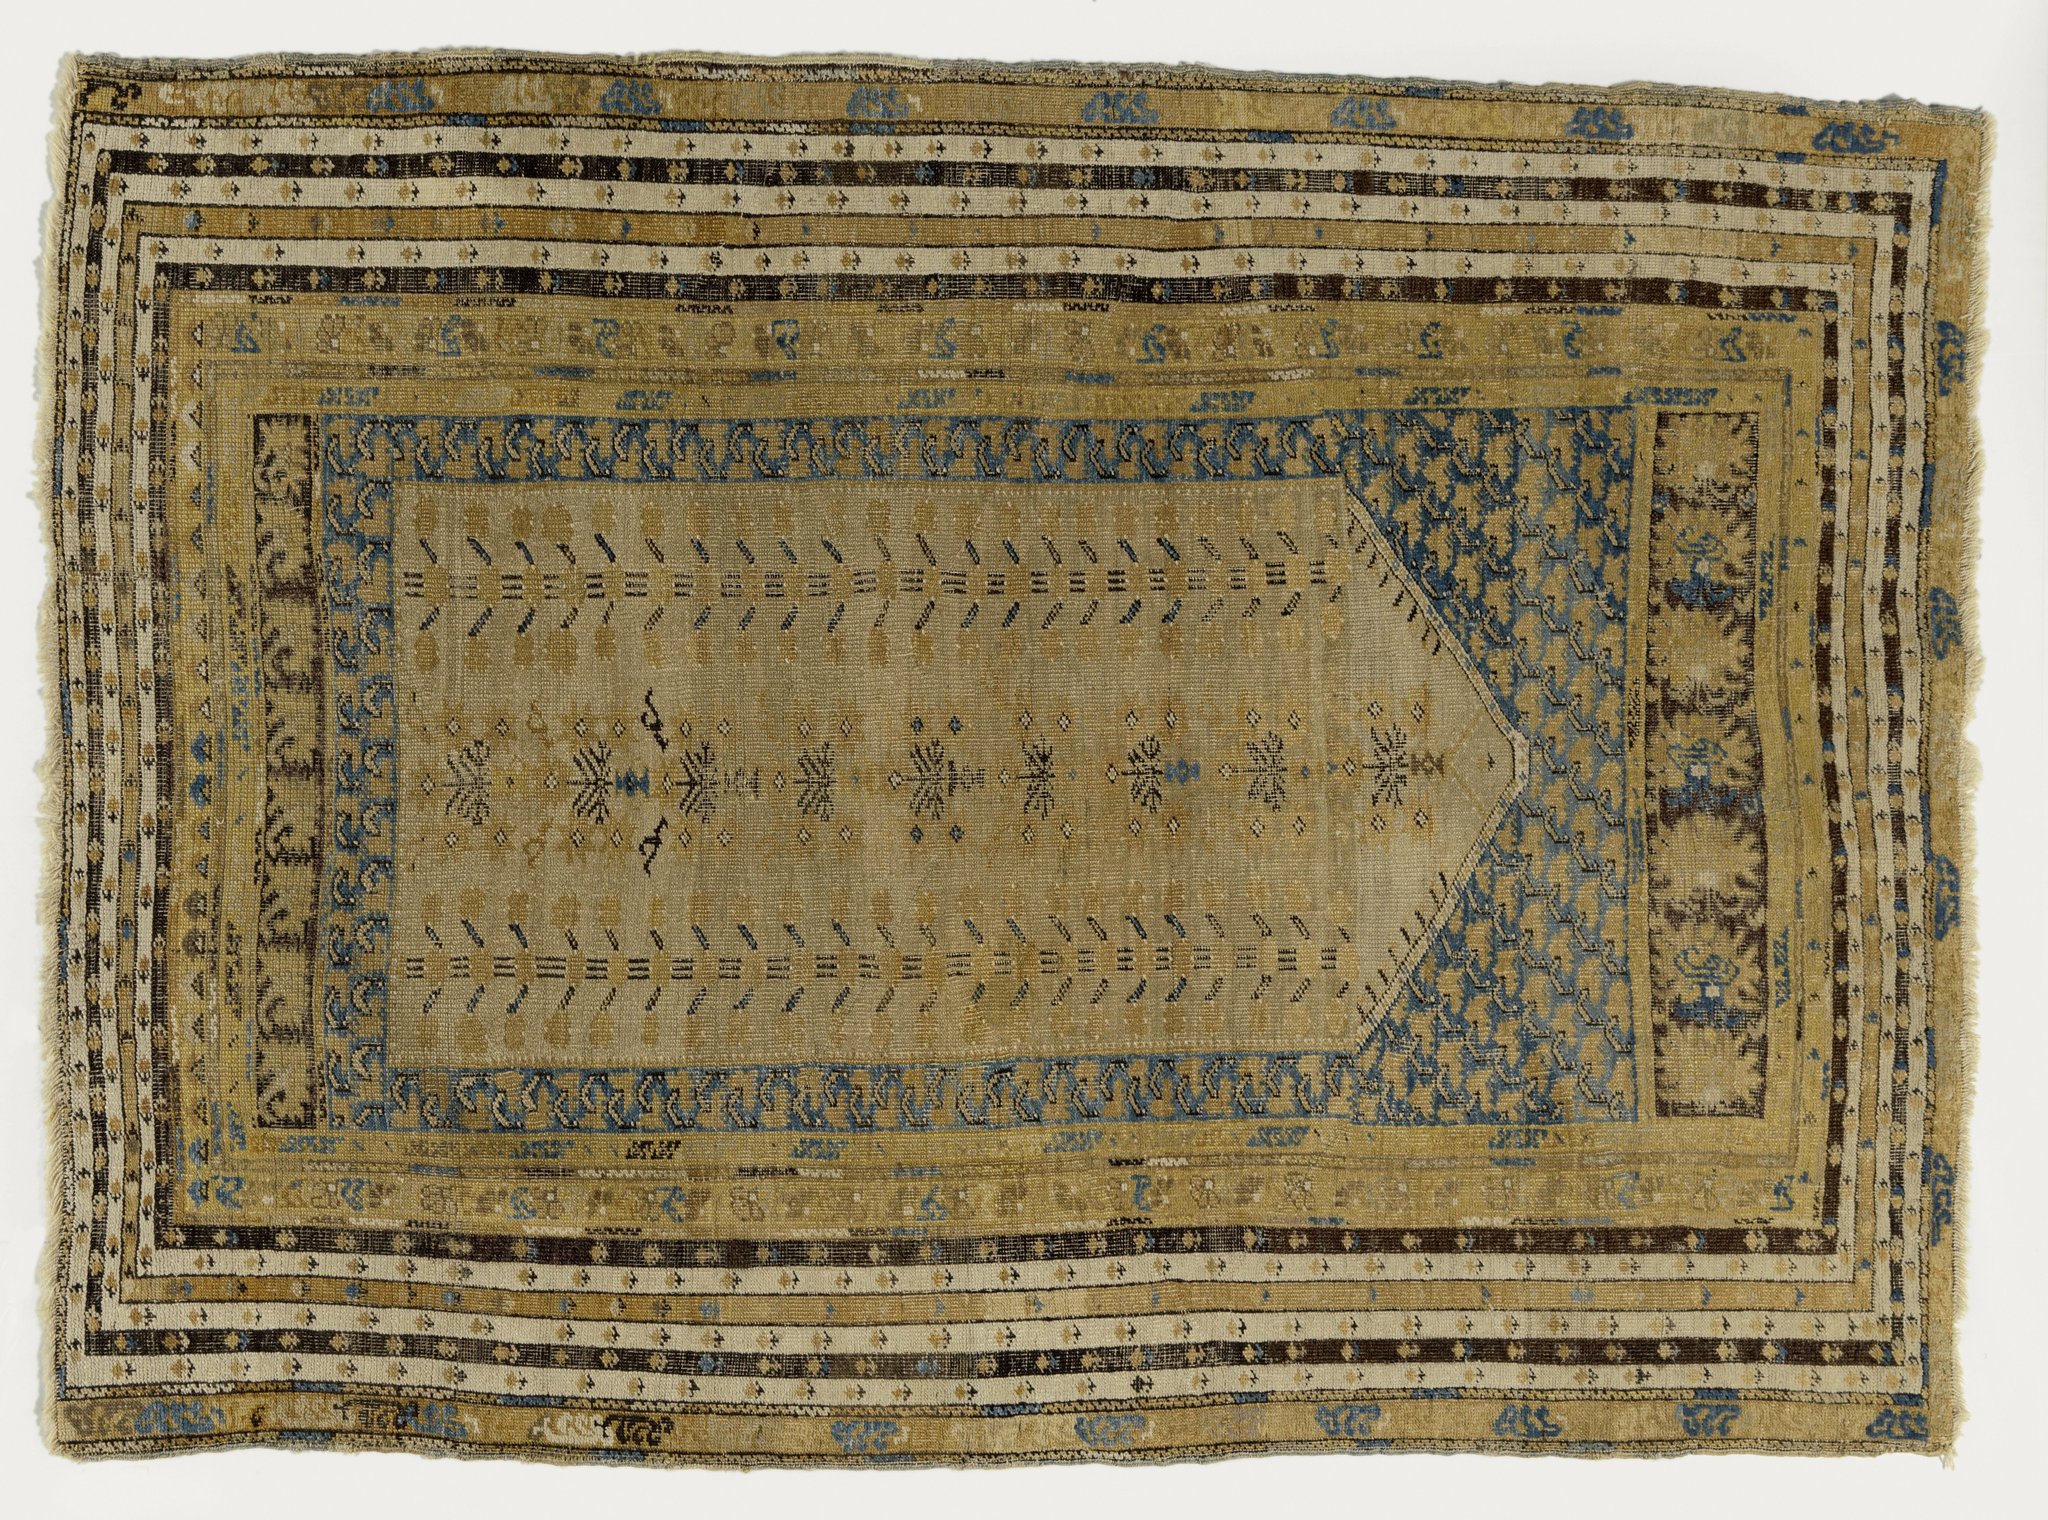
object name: tapijt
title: Bidkleed met twee dwarspanelen, KULA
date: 1800-1900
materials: wool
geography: kula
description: Bidkleed met twee dwarspanelen, KULA. Middenveld: rondom een grijsbeige mihrab met vlakke, rechtlijnige geveltop en twee kolommen van stengels met bloemen, loopt een koblatblauw randje met gele anjelieren, dat doorloopt als zwikken. Een breed bovenpaneel en een smal benedenpaneel hebben en zwarte fond, elk met een rij beige anjers. Randen: veelvoudig. Tussen okergele zomen met lopende bloemranken staan zes strepen in zwart, wit en oker.